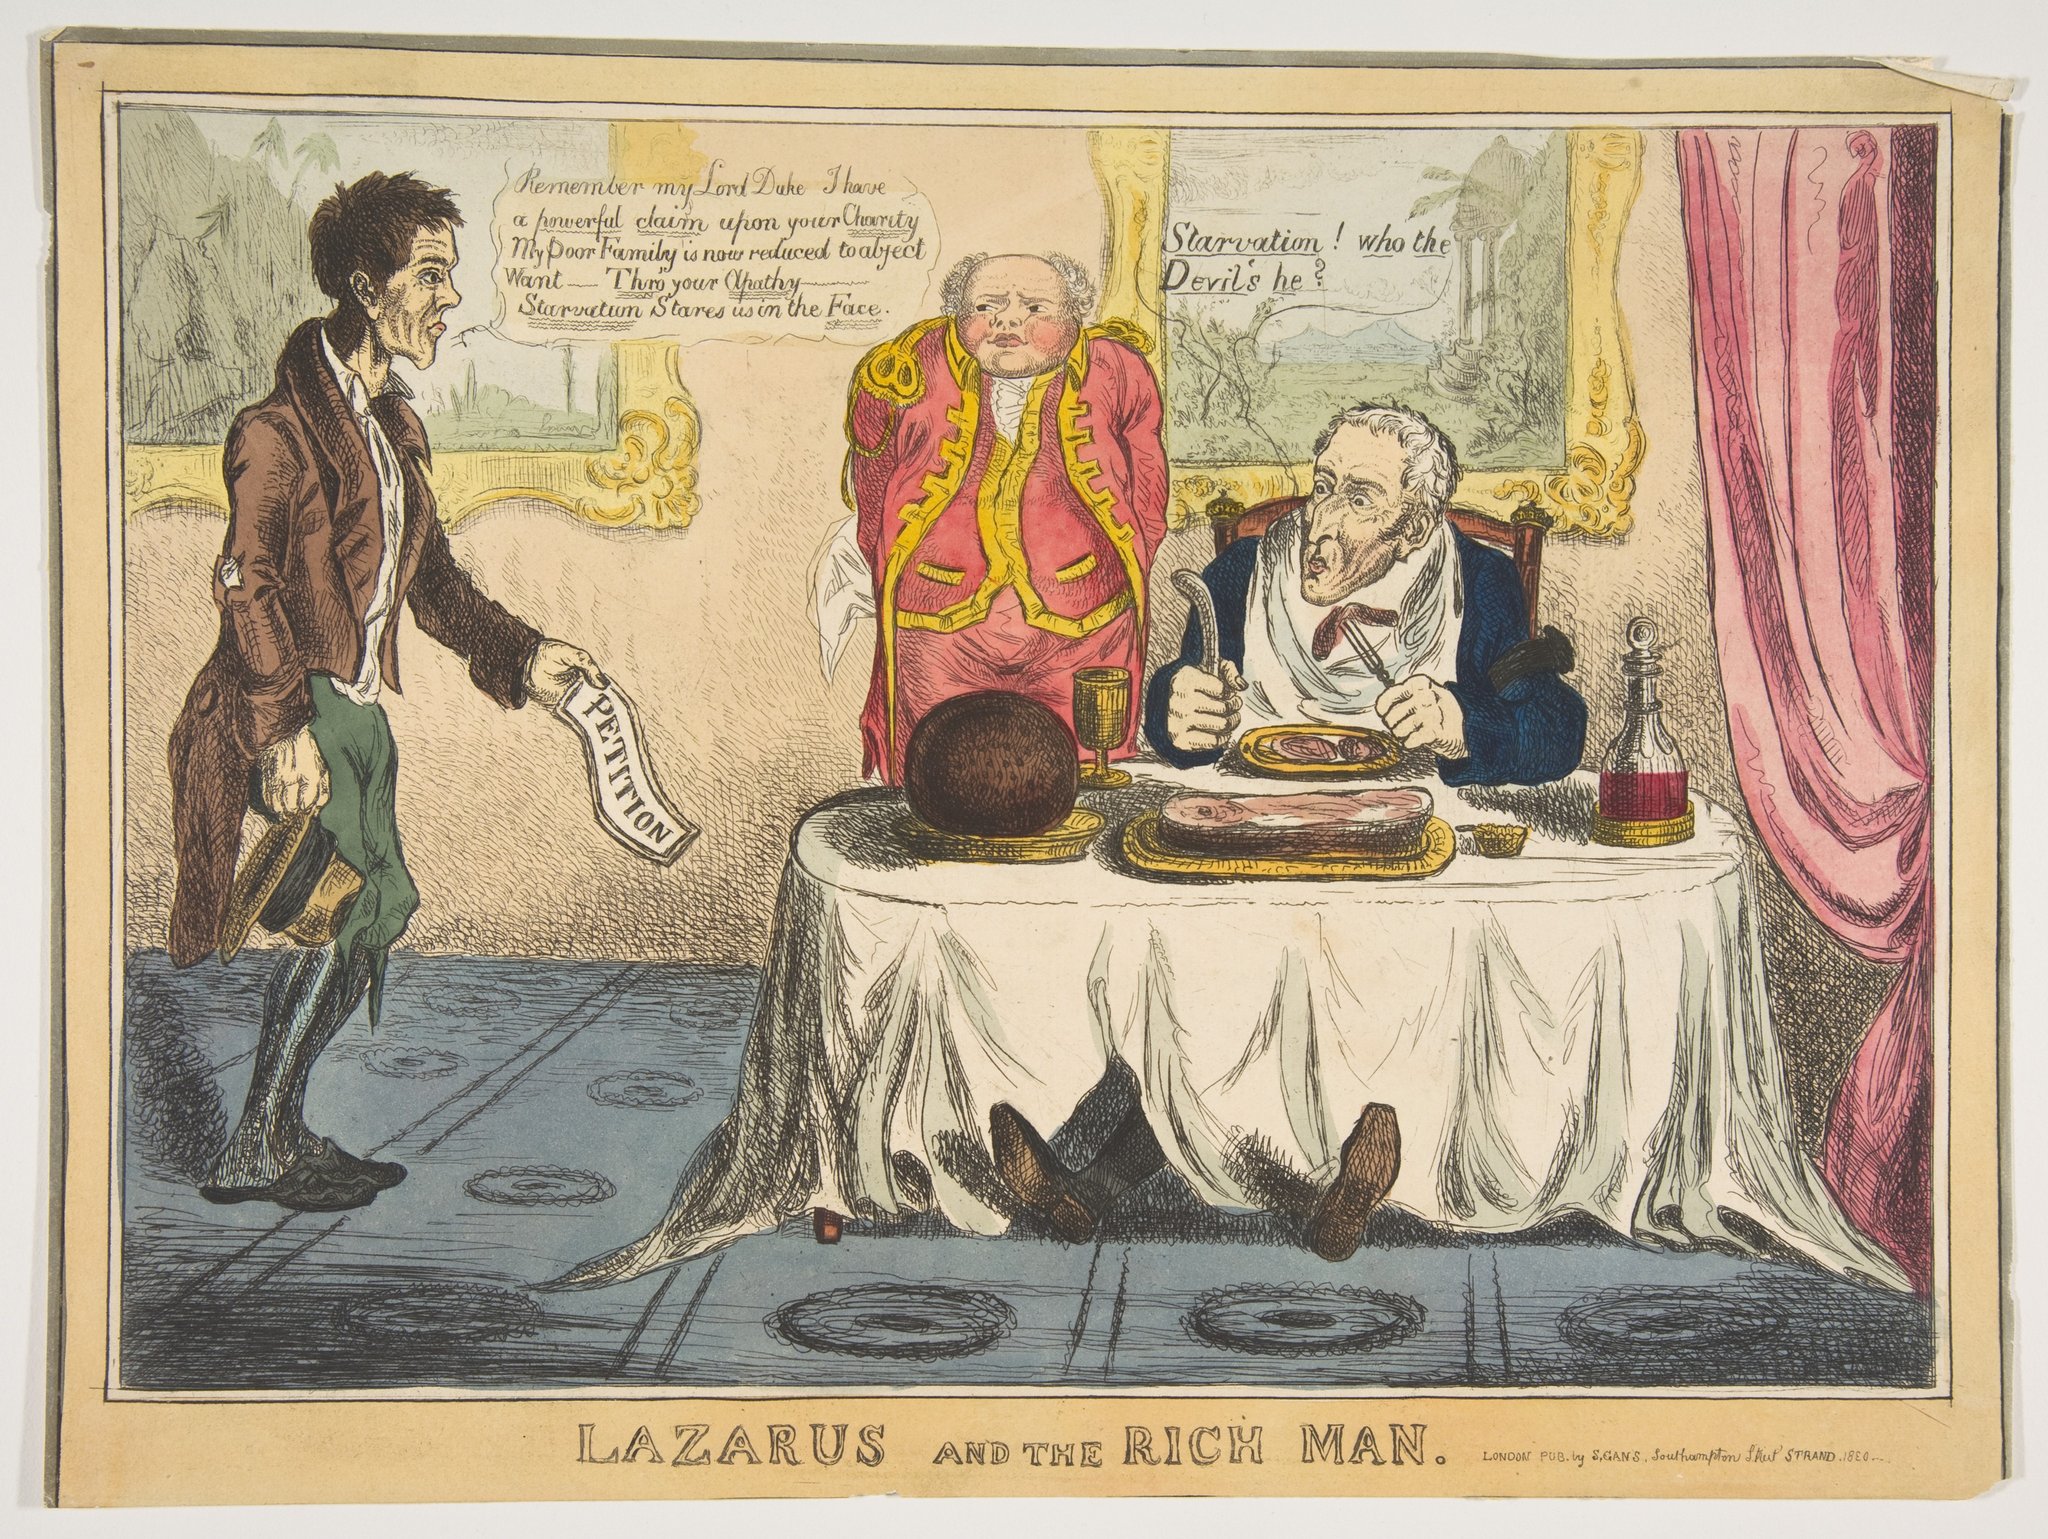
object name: print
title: Lazarus and the Rich Man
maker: anonymous, british, 19th century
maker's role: artist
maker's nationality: british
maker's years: 1800-1900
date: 1830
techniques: etching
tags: food,satire,men,dining,politics